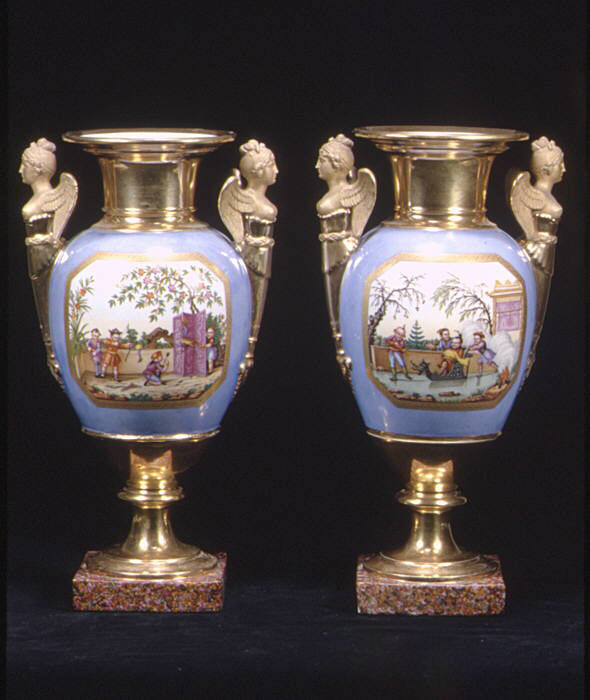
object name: vase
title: Pair of vases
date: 1810-1820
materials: hard paste porcelain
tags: chinoiserie,children,playing